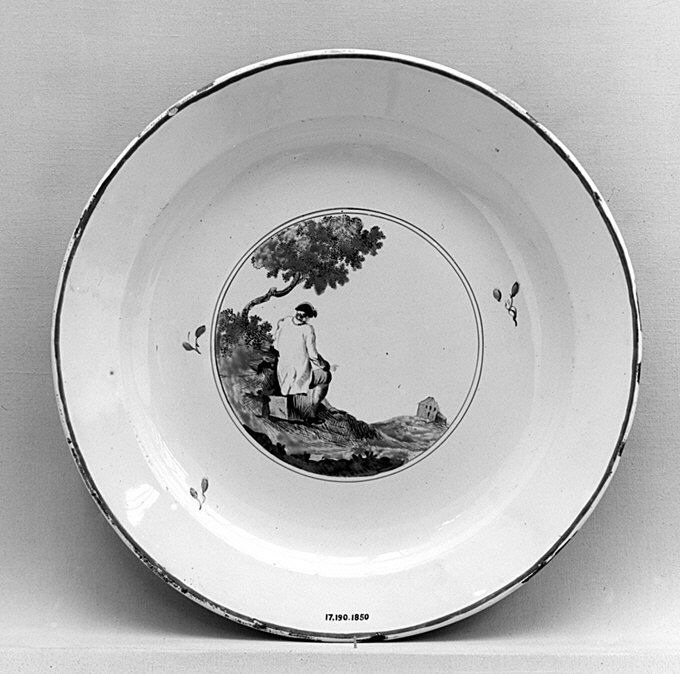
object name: plate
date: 1785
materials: faience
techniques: glazing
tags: men,trees